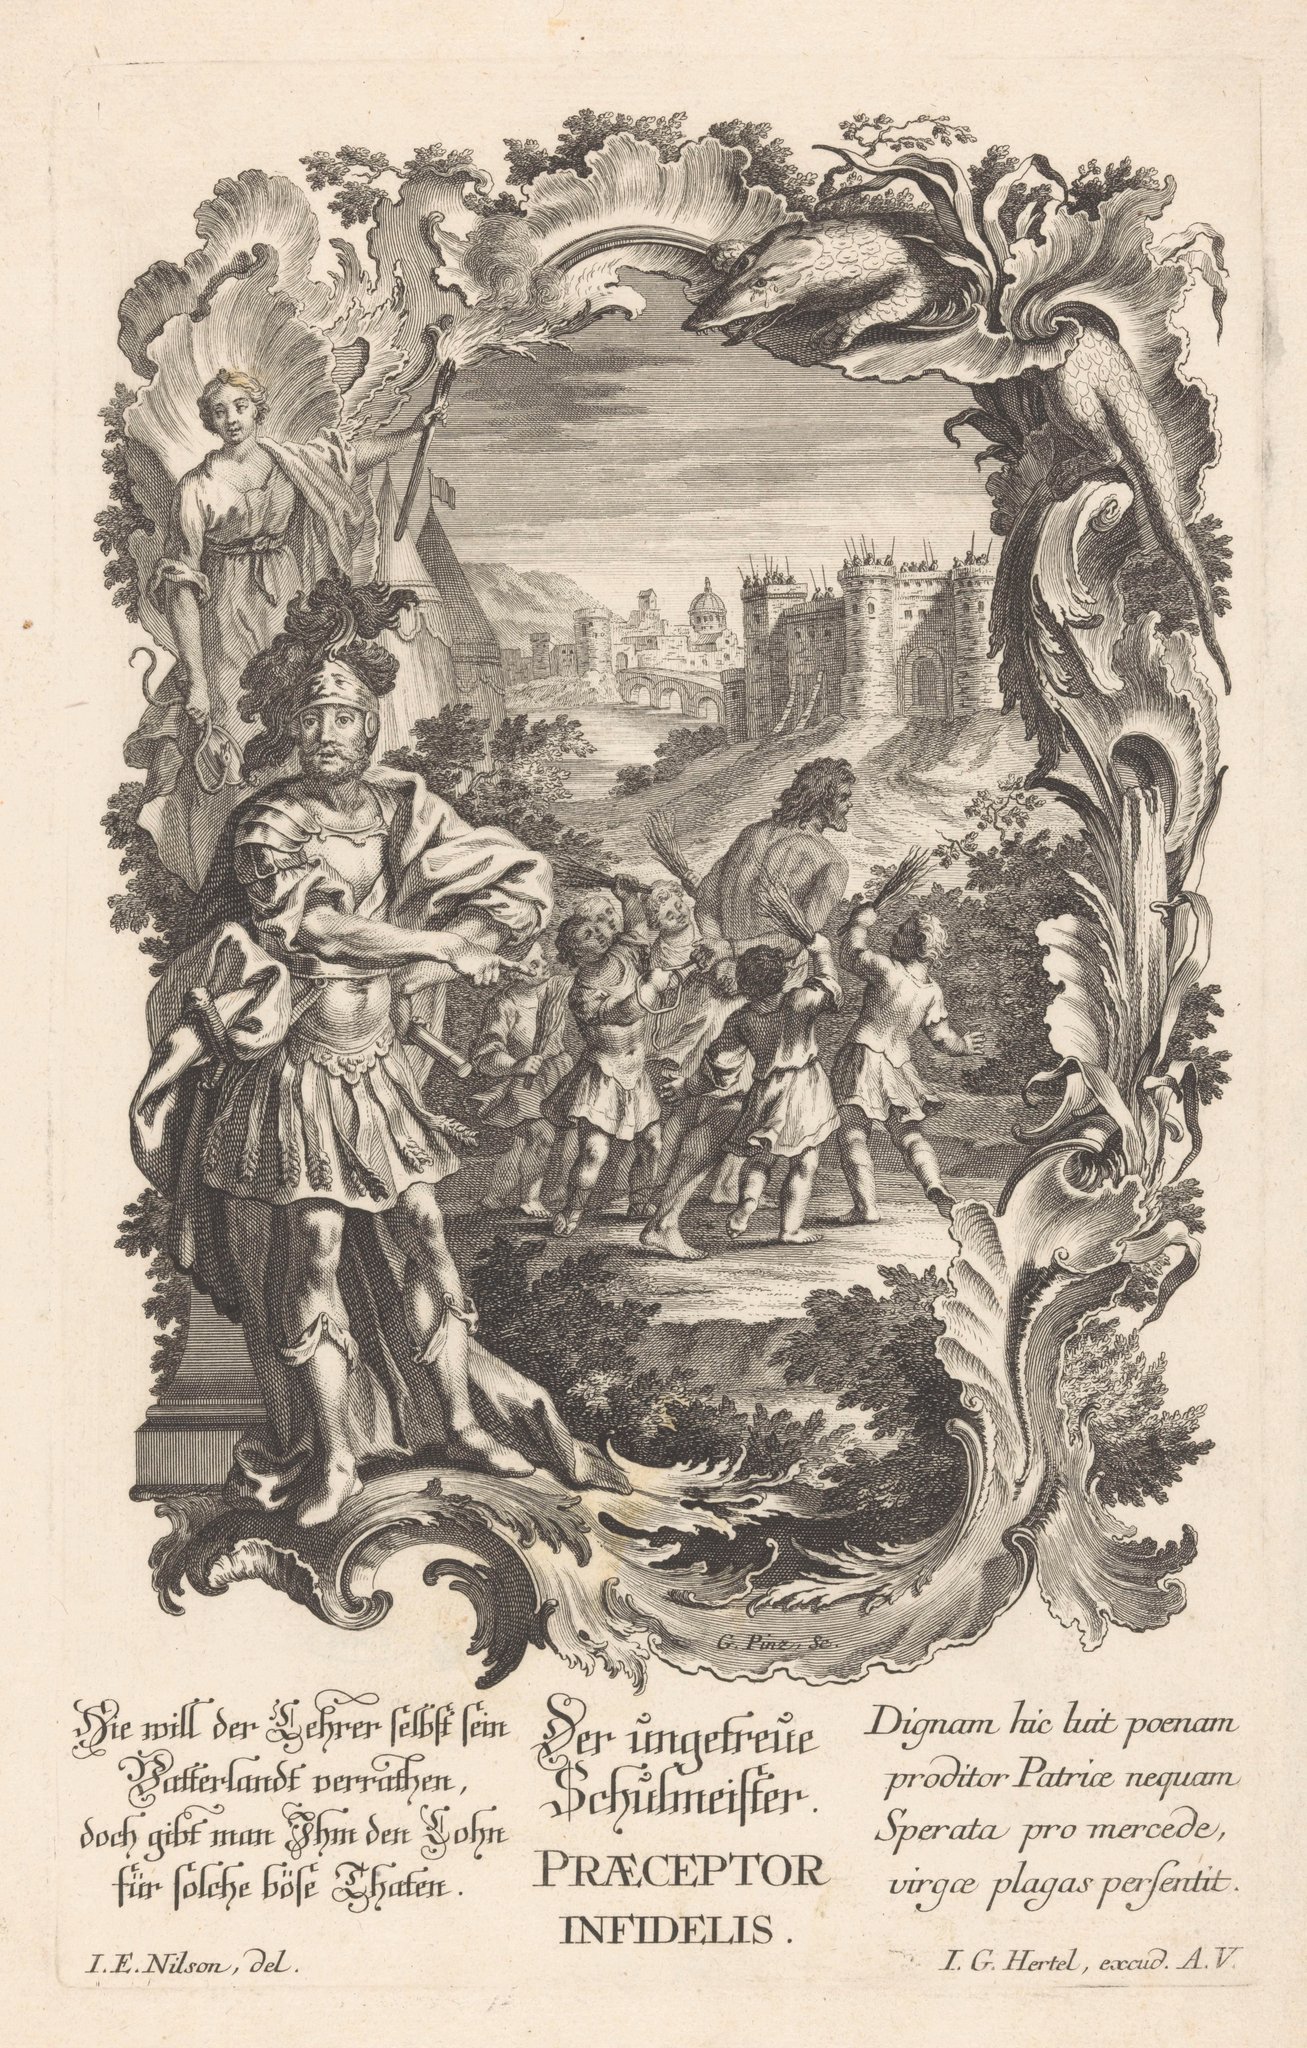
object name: print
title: Ontrouwe schoolmeester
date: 1731-1767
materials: paper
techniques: engraving, etching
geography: augsburg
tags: prudence, 'prudentia'; 'prudenza' (ripa) ~ one of the four cardinal virtues, (story of) mars (ares), pupil punishing teacher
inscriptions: collector's mark: Lugt 2228, collector's mark: Lugt 2760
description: Een kleine groep kinderen leidt een ontrouwe leraar richting de vesting in de achtergrond. De leraar is geboeid en wordt door de kinderen met roedes geslagen. Rondom de voorstelling een rocaille omlijsting met de god Mars in harnas en een vrouwelijke personificatie van de voorzichtigheid met slang, spiegel en fakkel in haar handen. In de ondermarge tweemaal een vierregelige Duitse en Latijnse tekst.